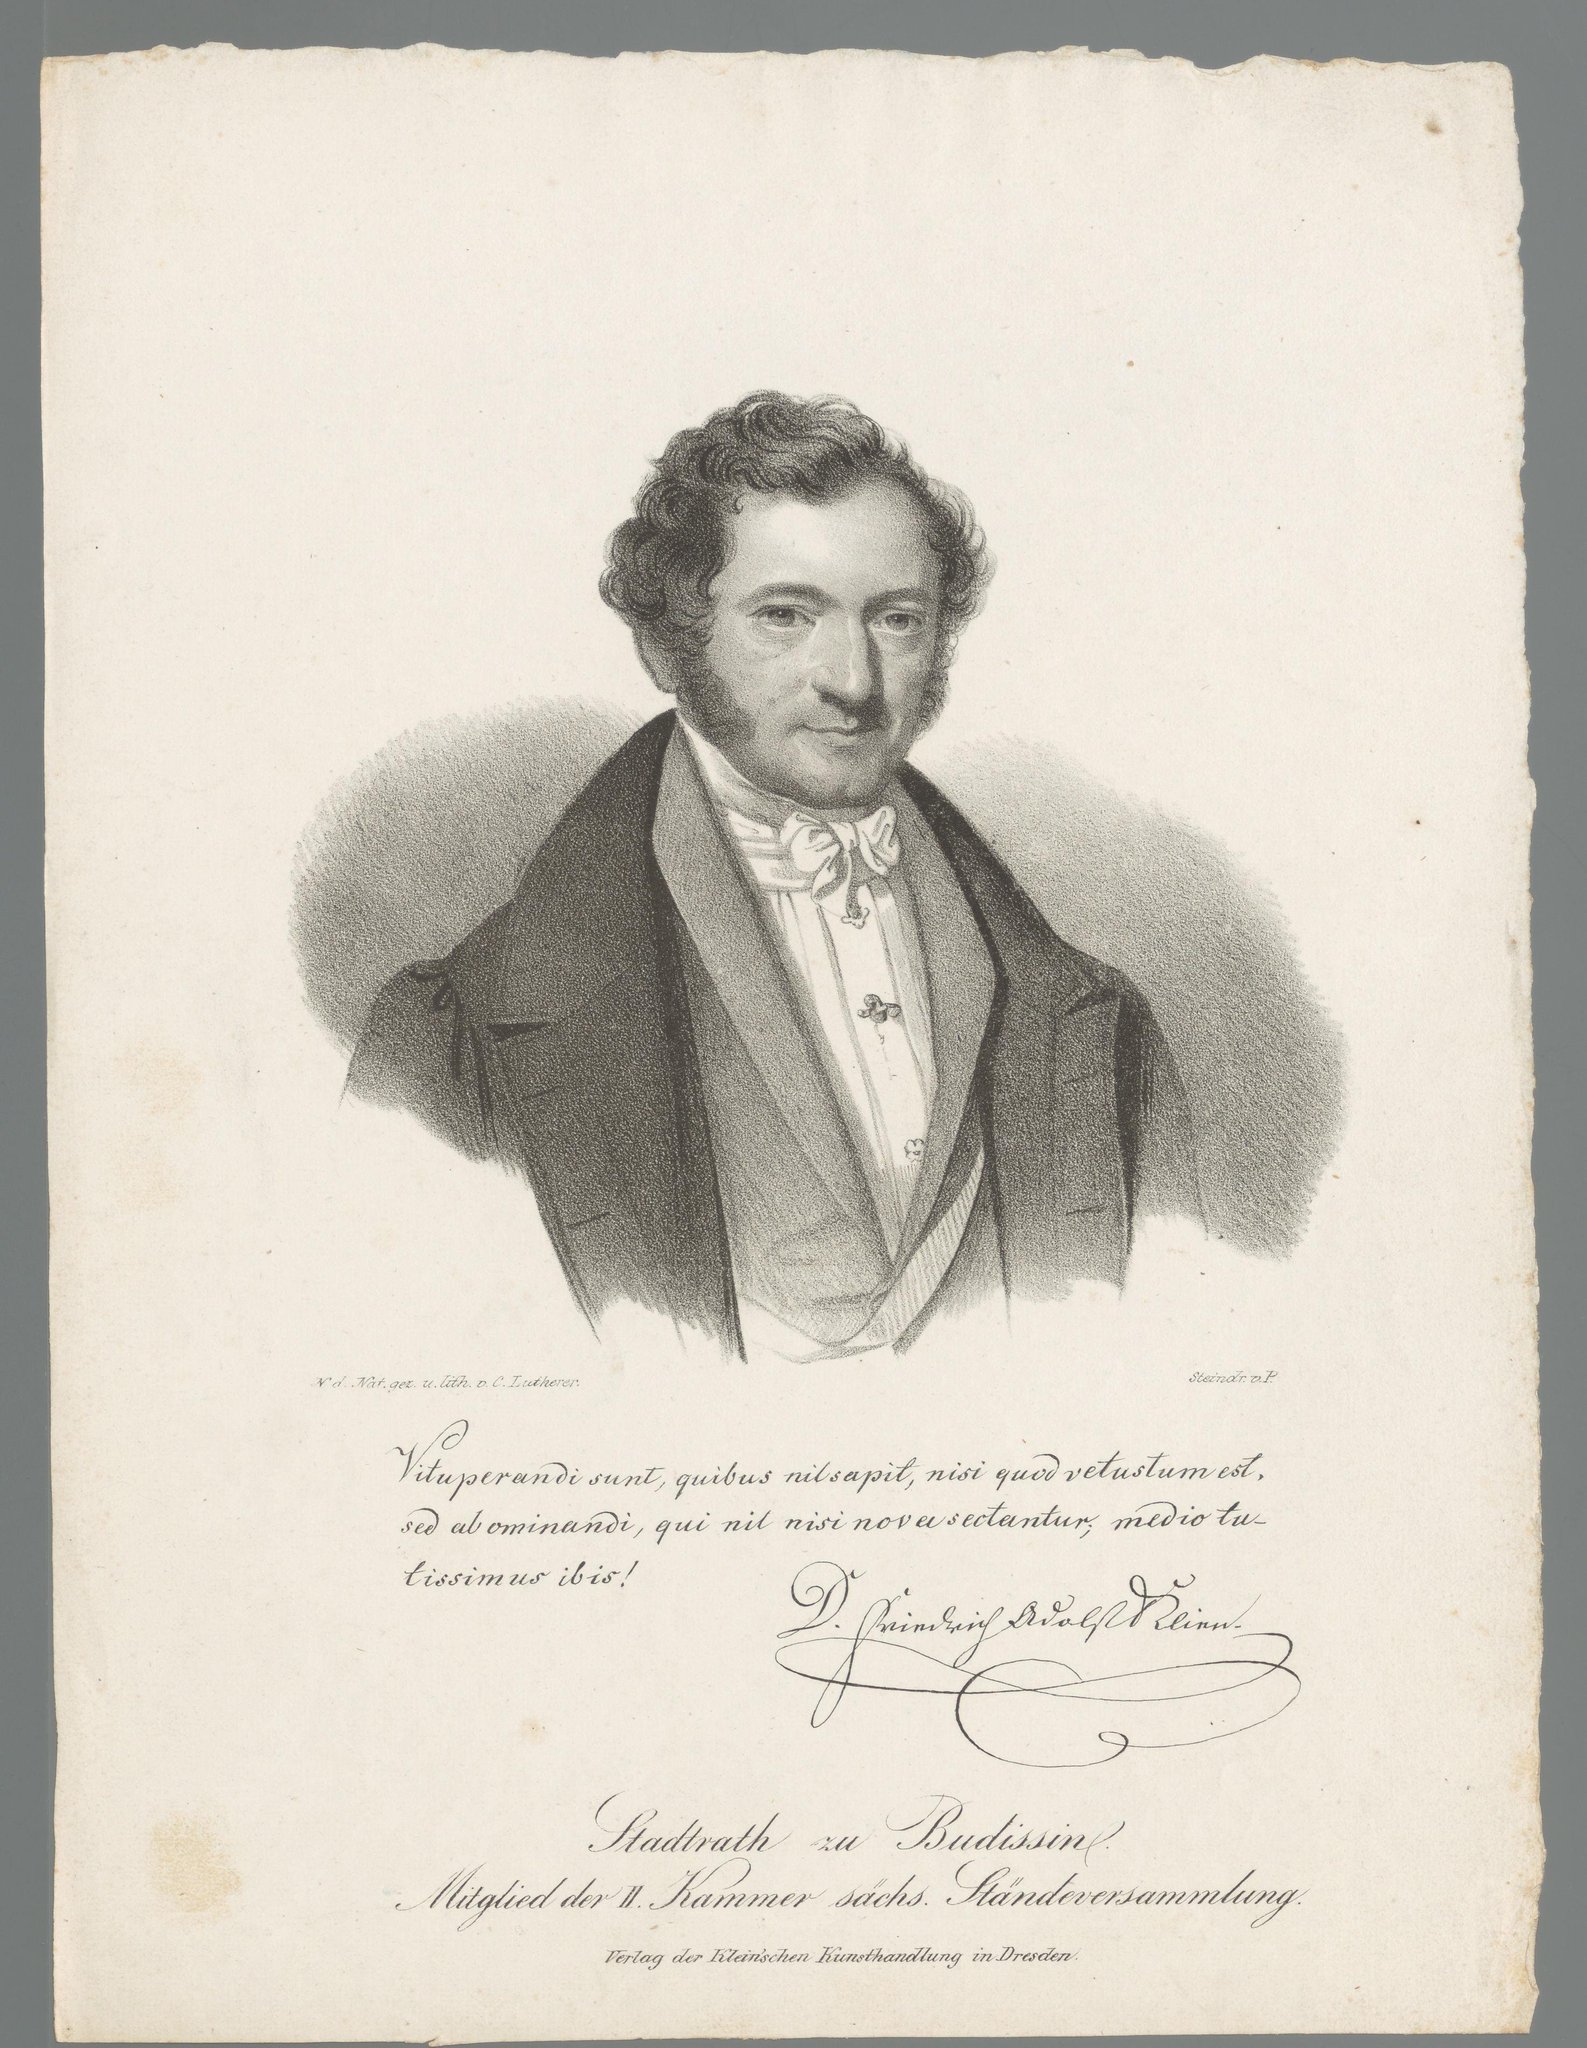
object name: print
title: Portret van Friedrich Adolph Klien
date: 1817-1850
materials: paper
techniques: lithograph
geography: dresden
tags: politician, e.g. party leader, historical persons not known by name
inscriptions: collector's mark: Lugt 2228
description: Portret van een verder onbekende politicus met de naam Friedrich Adolph Klien.